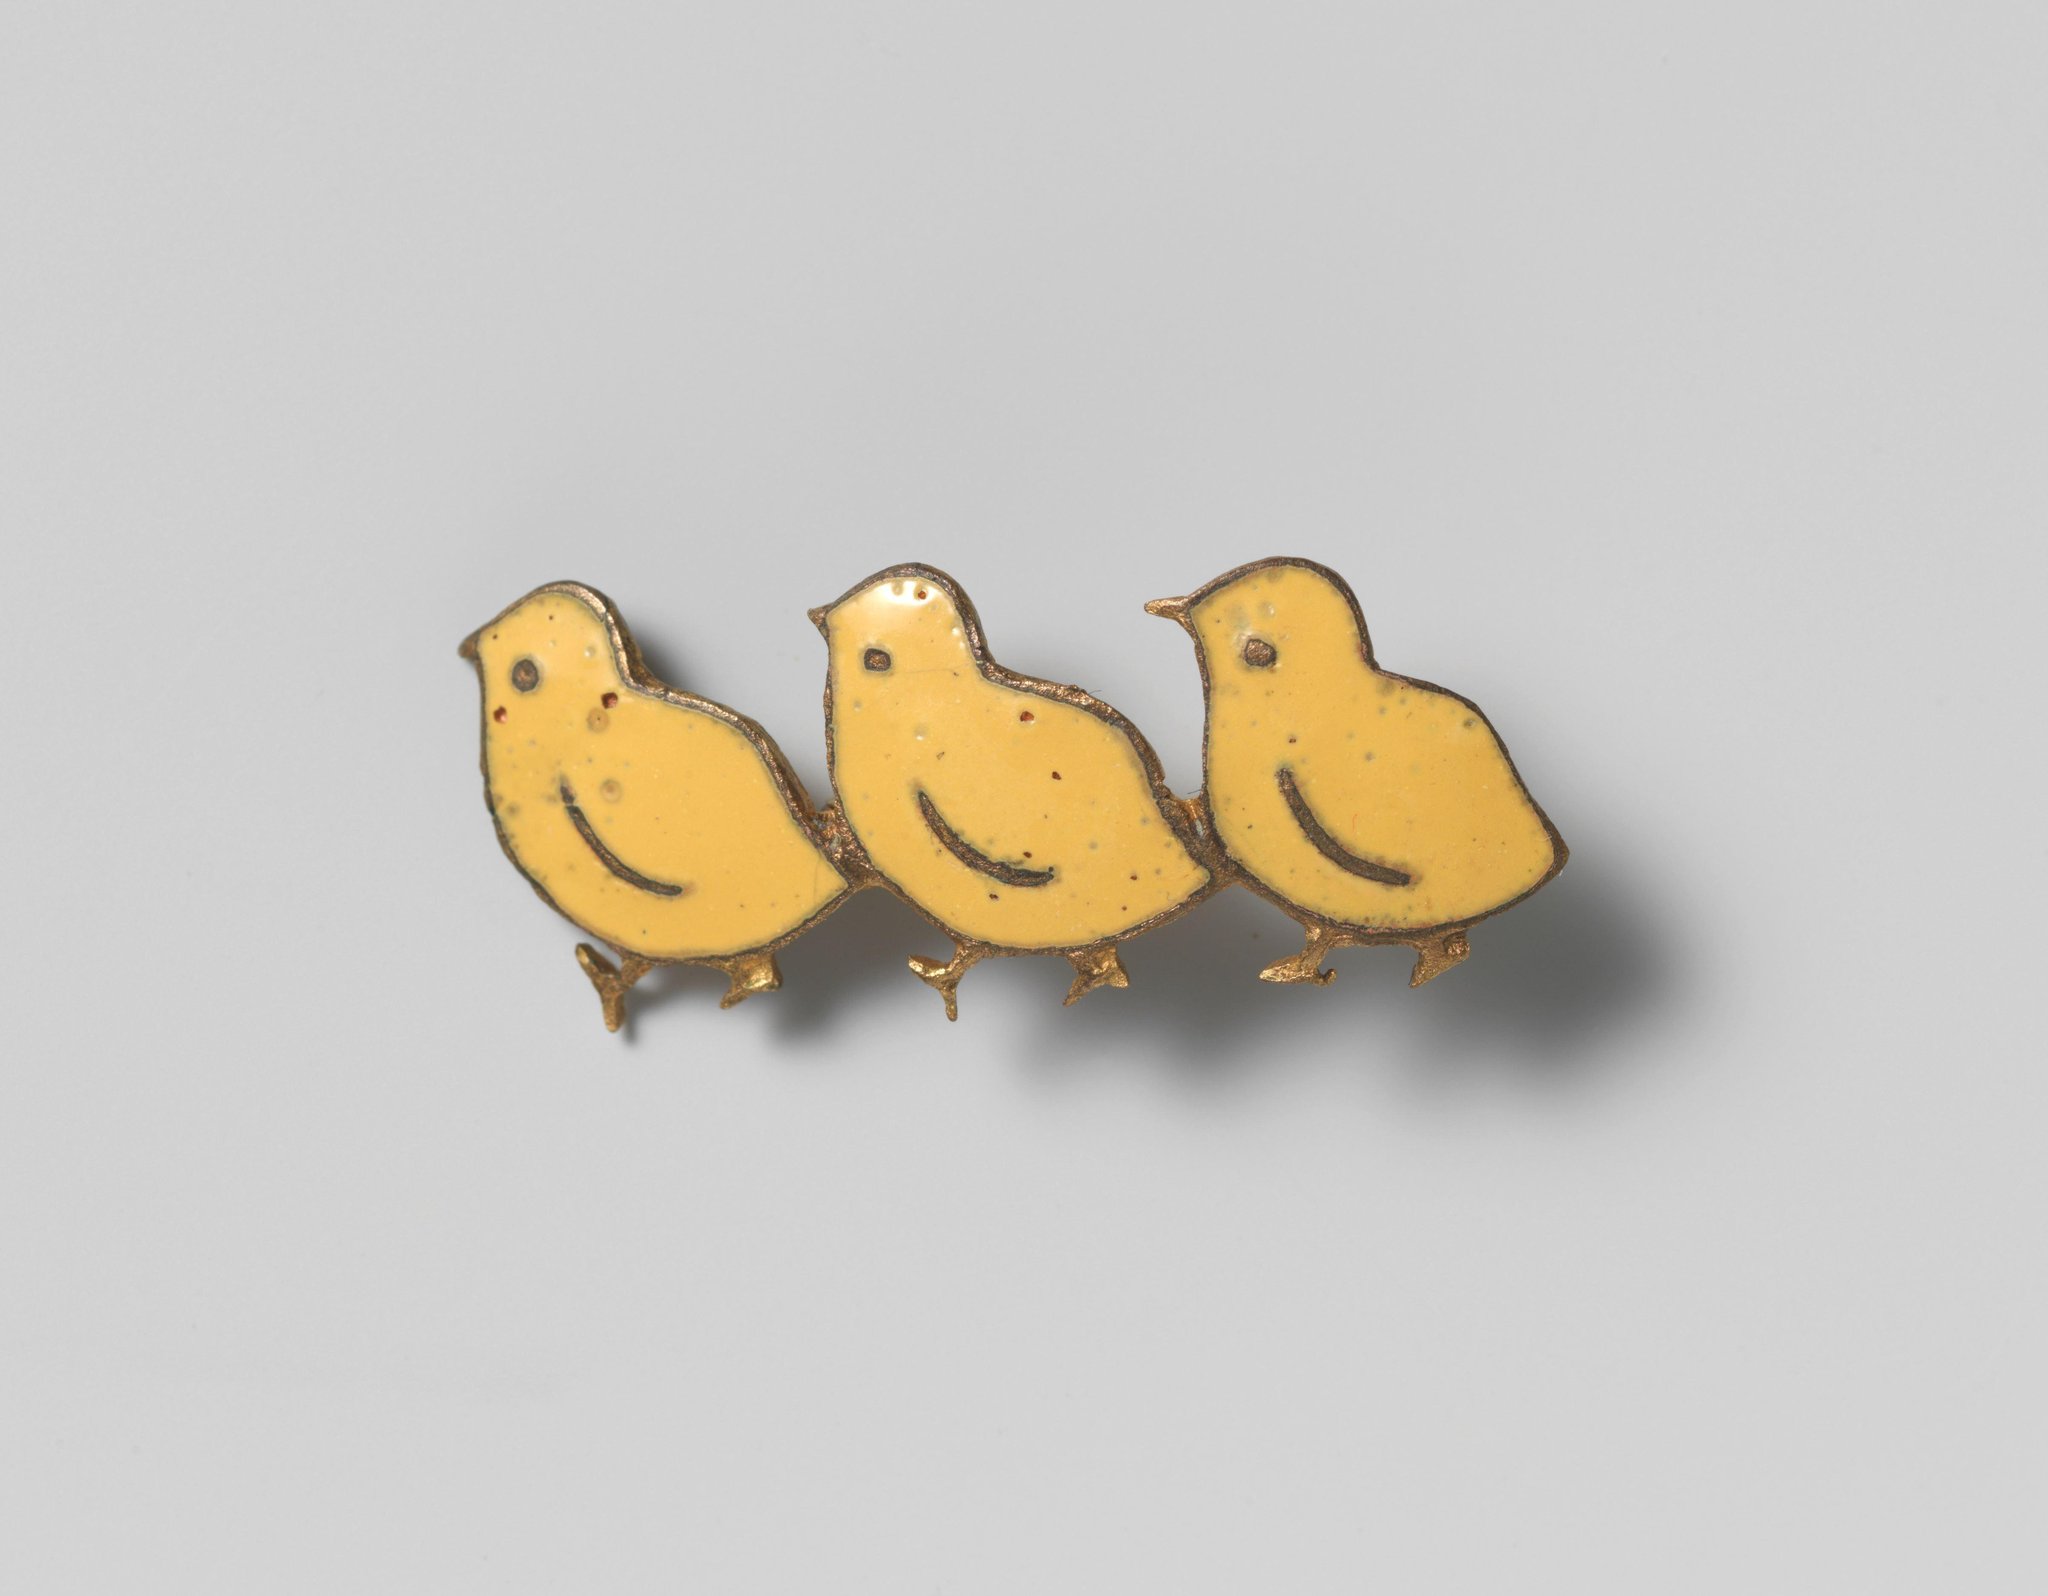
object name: brooch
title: Brooch in the form of three yellow chicks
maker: Anonymous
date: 1943-1945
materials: metal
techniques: enameling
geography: netherlands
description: Silent Resistance – War and Liberation Jewellery During the Second World War, small pieces of jewellery were worn in the Netherlands as a silent protest against the German occupier. In April 1941, Dutch coins were officially confiscated for the war industry. As jewellery did not have to be surrendered, coins were quickly transformed into rings, brooches, pins and bracelets. A portrait of Queen Wilhelmina was worn as a sign of resistance, as well as a token of loyalty to the royal family. Margriet Francisca, the third daughter of Princess Juliana and Prince Bernard, was born in Canada in January 1943. The pin with the three yellow chicks refers to the three young princesses Beatrix, Irene and Margriet and the steadfastness of the Dutch royal family. After the liberation, coins and silver were used for jewellery conveying messages of hope for a peaceful future.